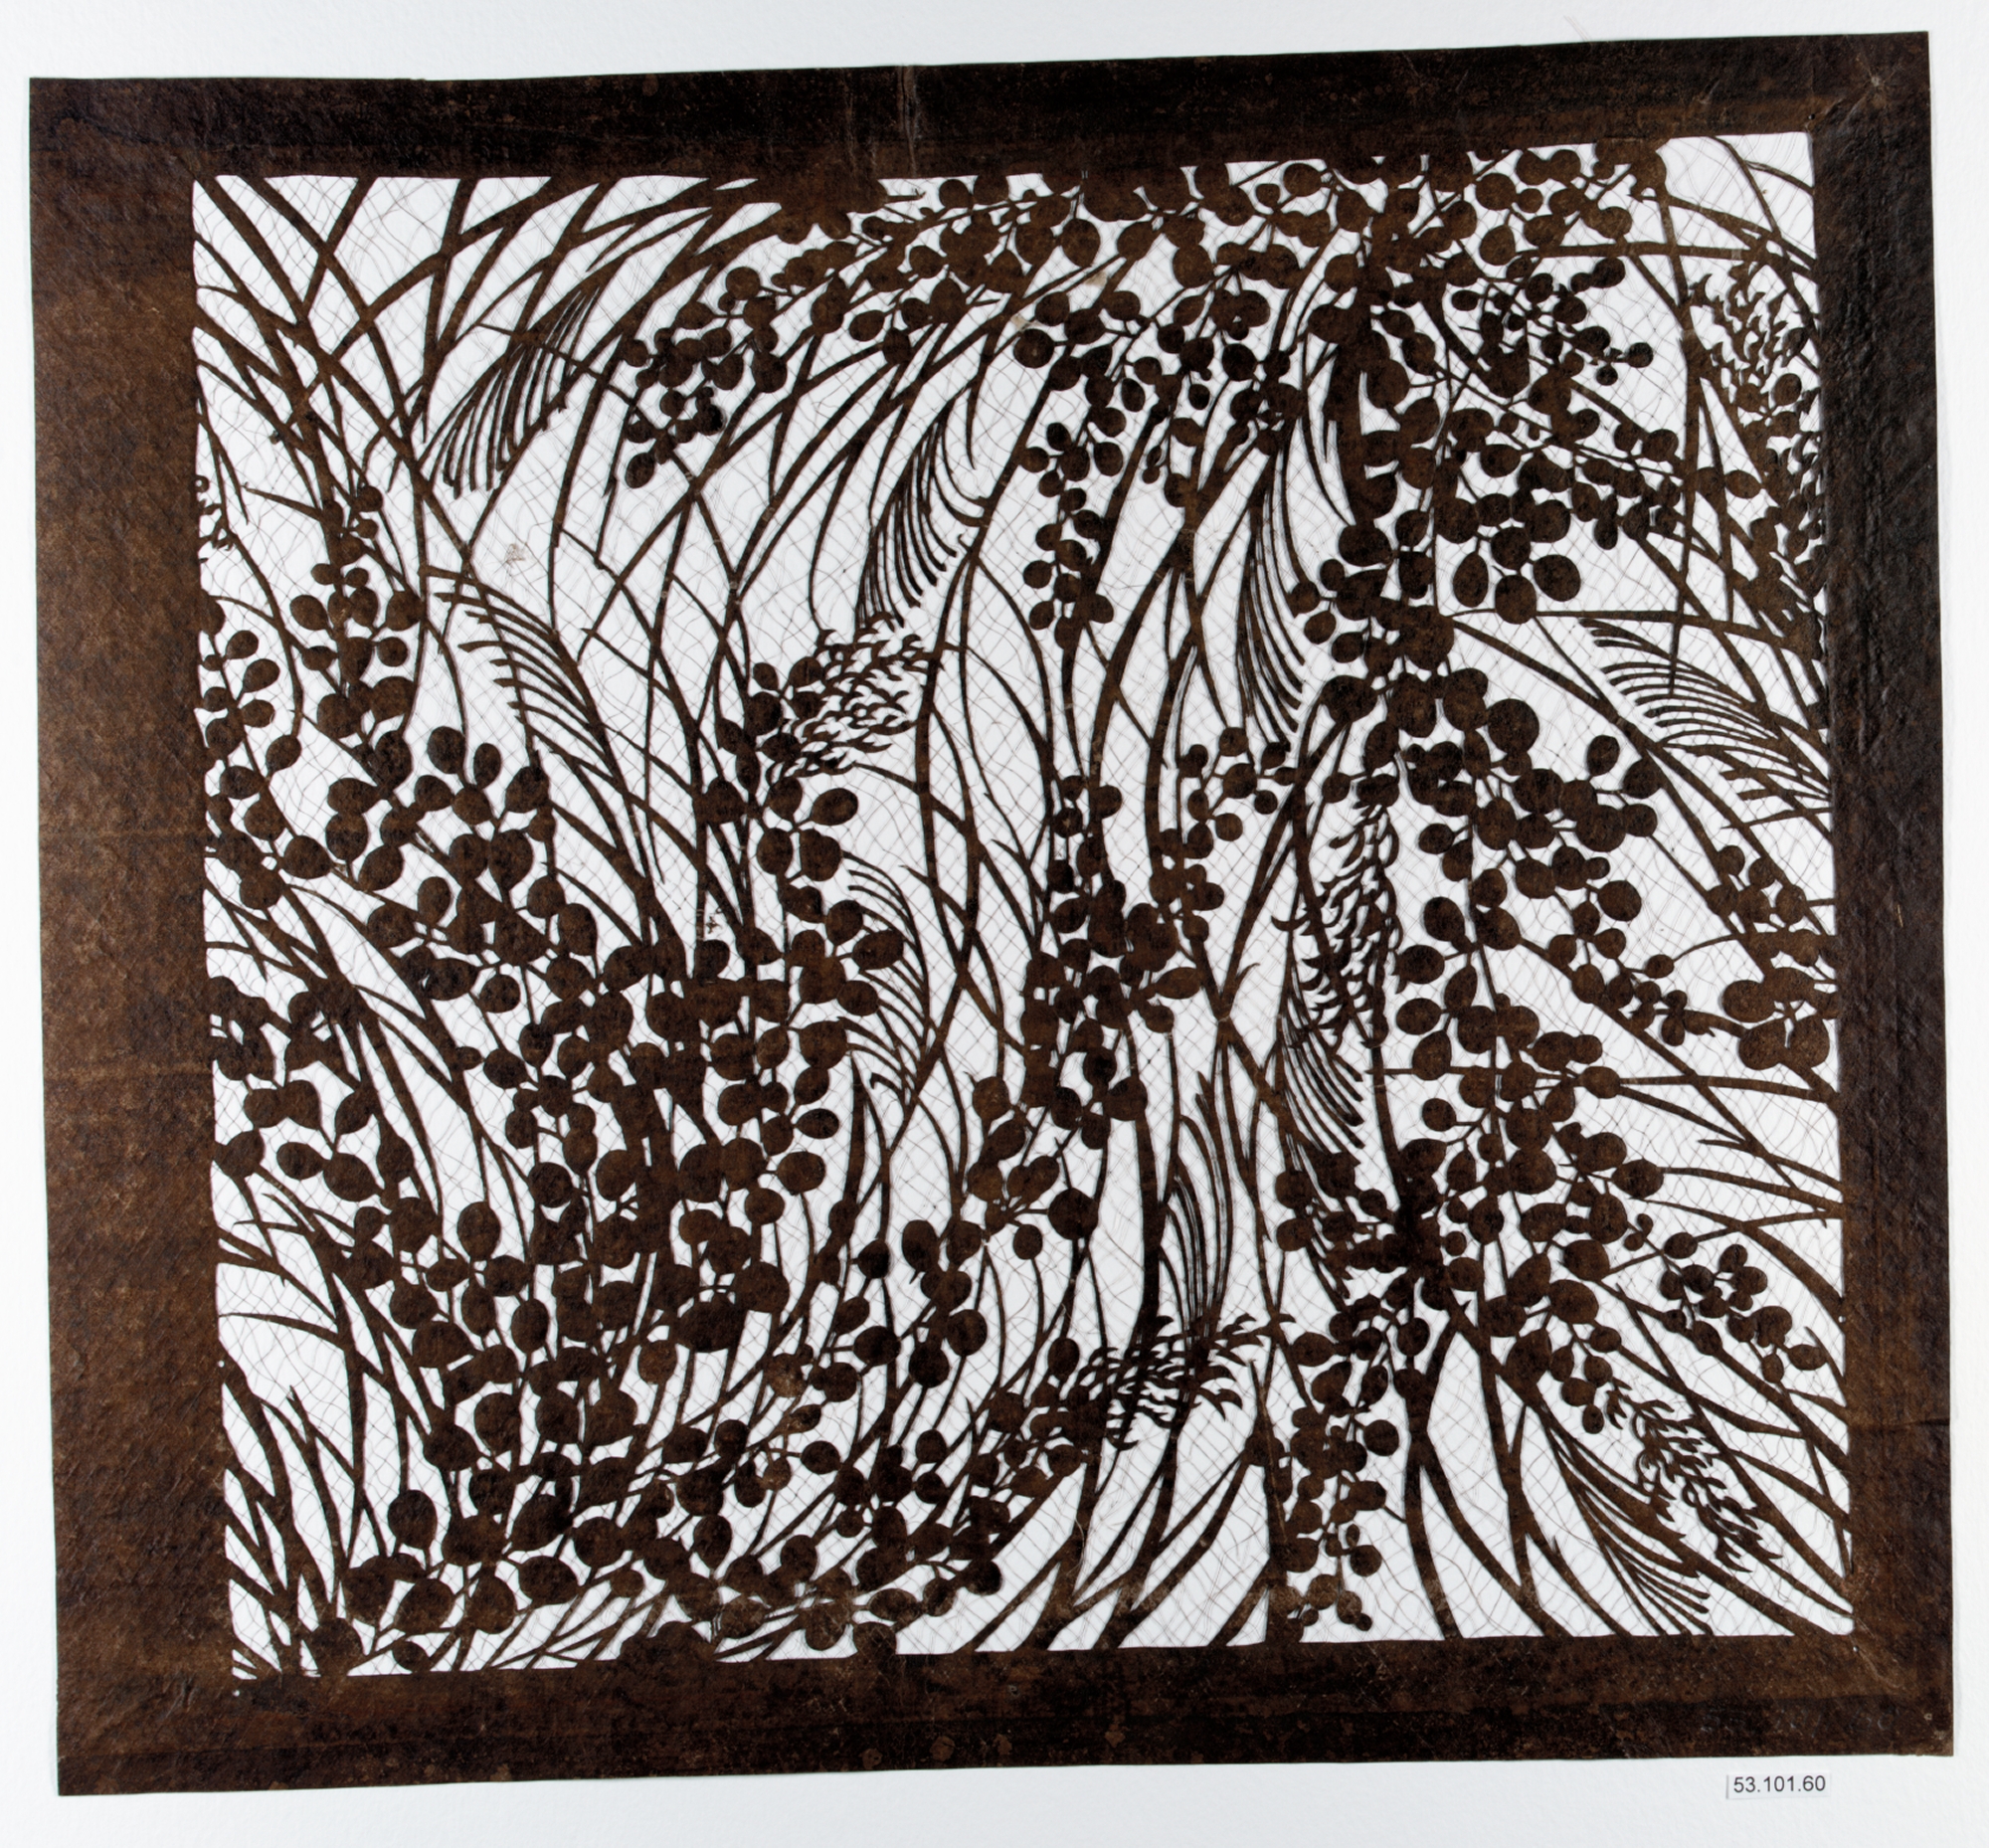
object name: stencil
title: Stencil with Sutumn Grasses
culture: japanese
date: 1615-1868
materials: paper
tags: plants